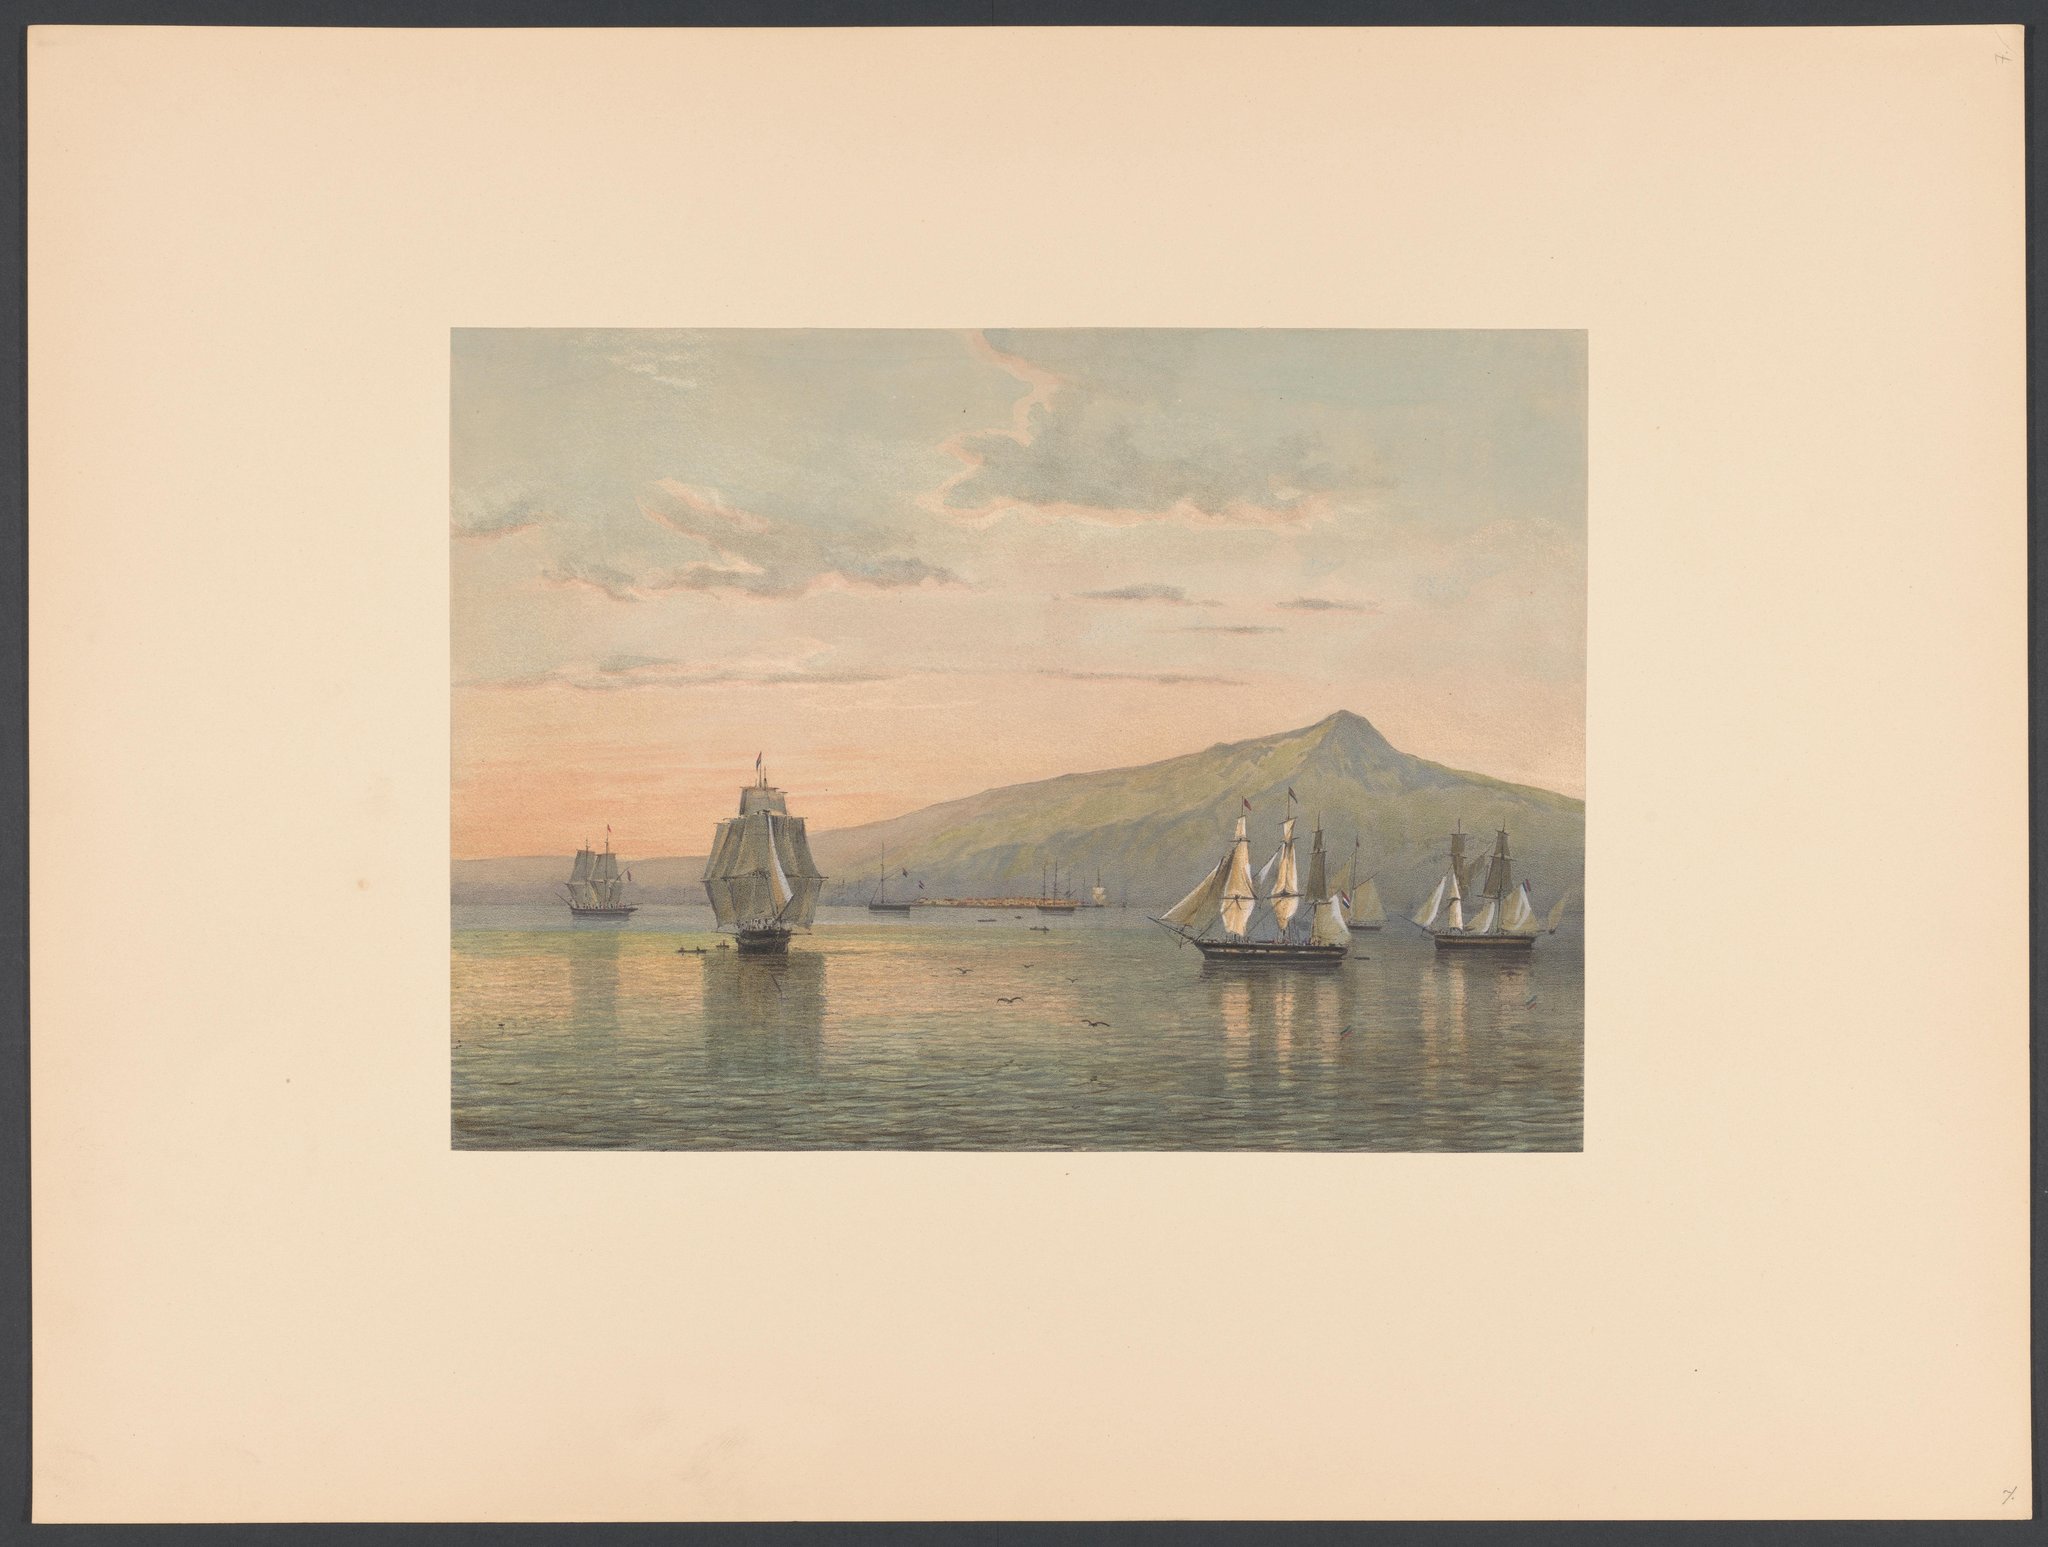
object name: print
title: Gezicht op de Straat Soenda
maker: johan conrad greive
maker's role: draughtsman, painter, print maker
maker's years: 1837-1891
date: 1865-1872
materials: paper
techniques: lithograph, hand coloring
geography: java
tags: sailing-ship, sailing-boat, landscapes (+ landscape with figures, staffage), mountains, java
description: Volgens de bijbehorende inhoudsopgave betreft dit de 7de prent uit de reeks van 24.